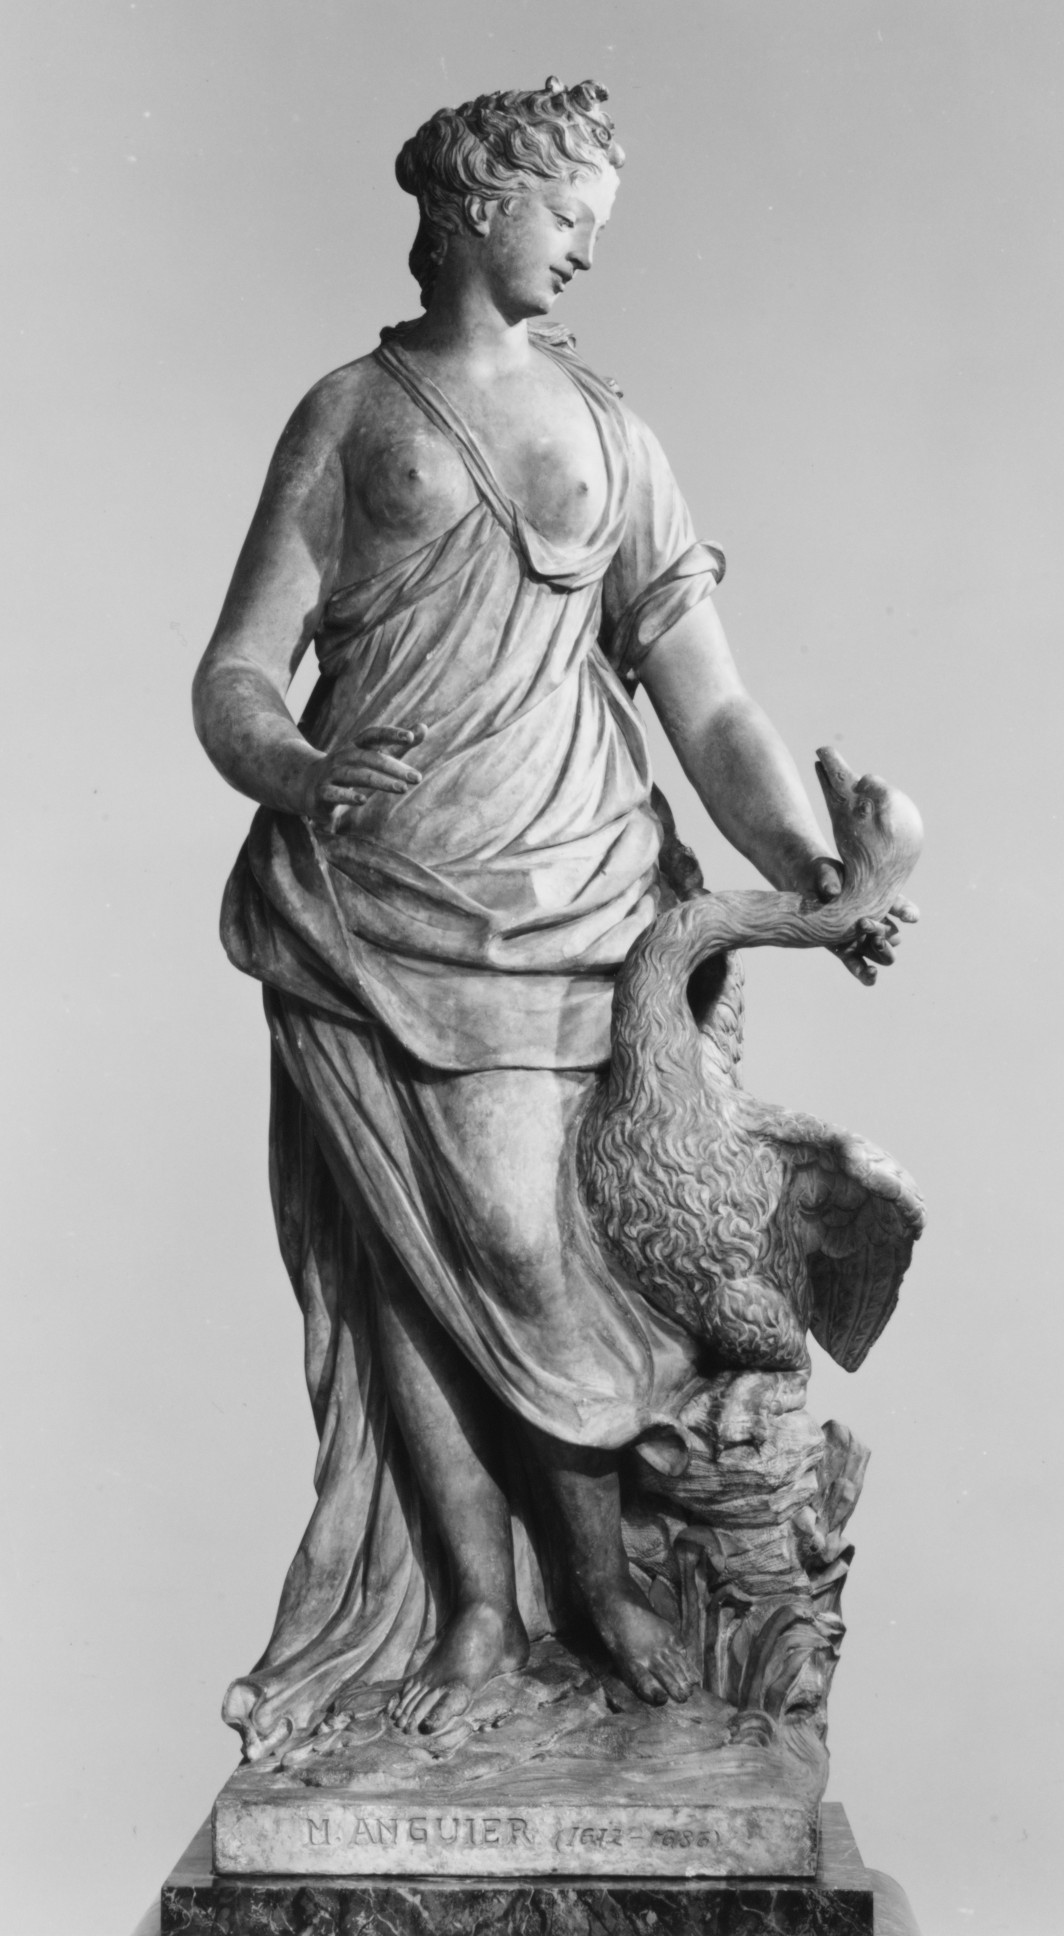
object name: group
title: Leda and the Swan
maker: michel anguier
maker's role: artist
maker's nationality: french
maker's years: 1612-1686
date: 1654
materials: limestone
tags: leda,swans